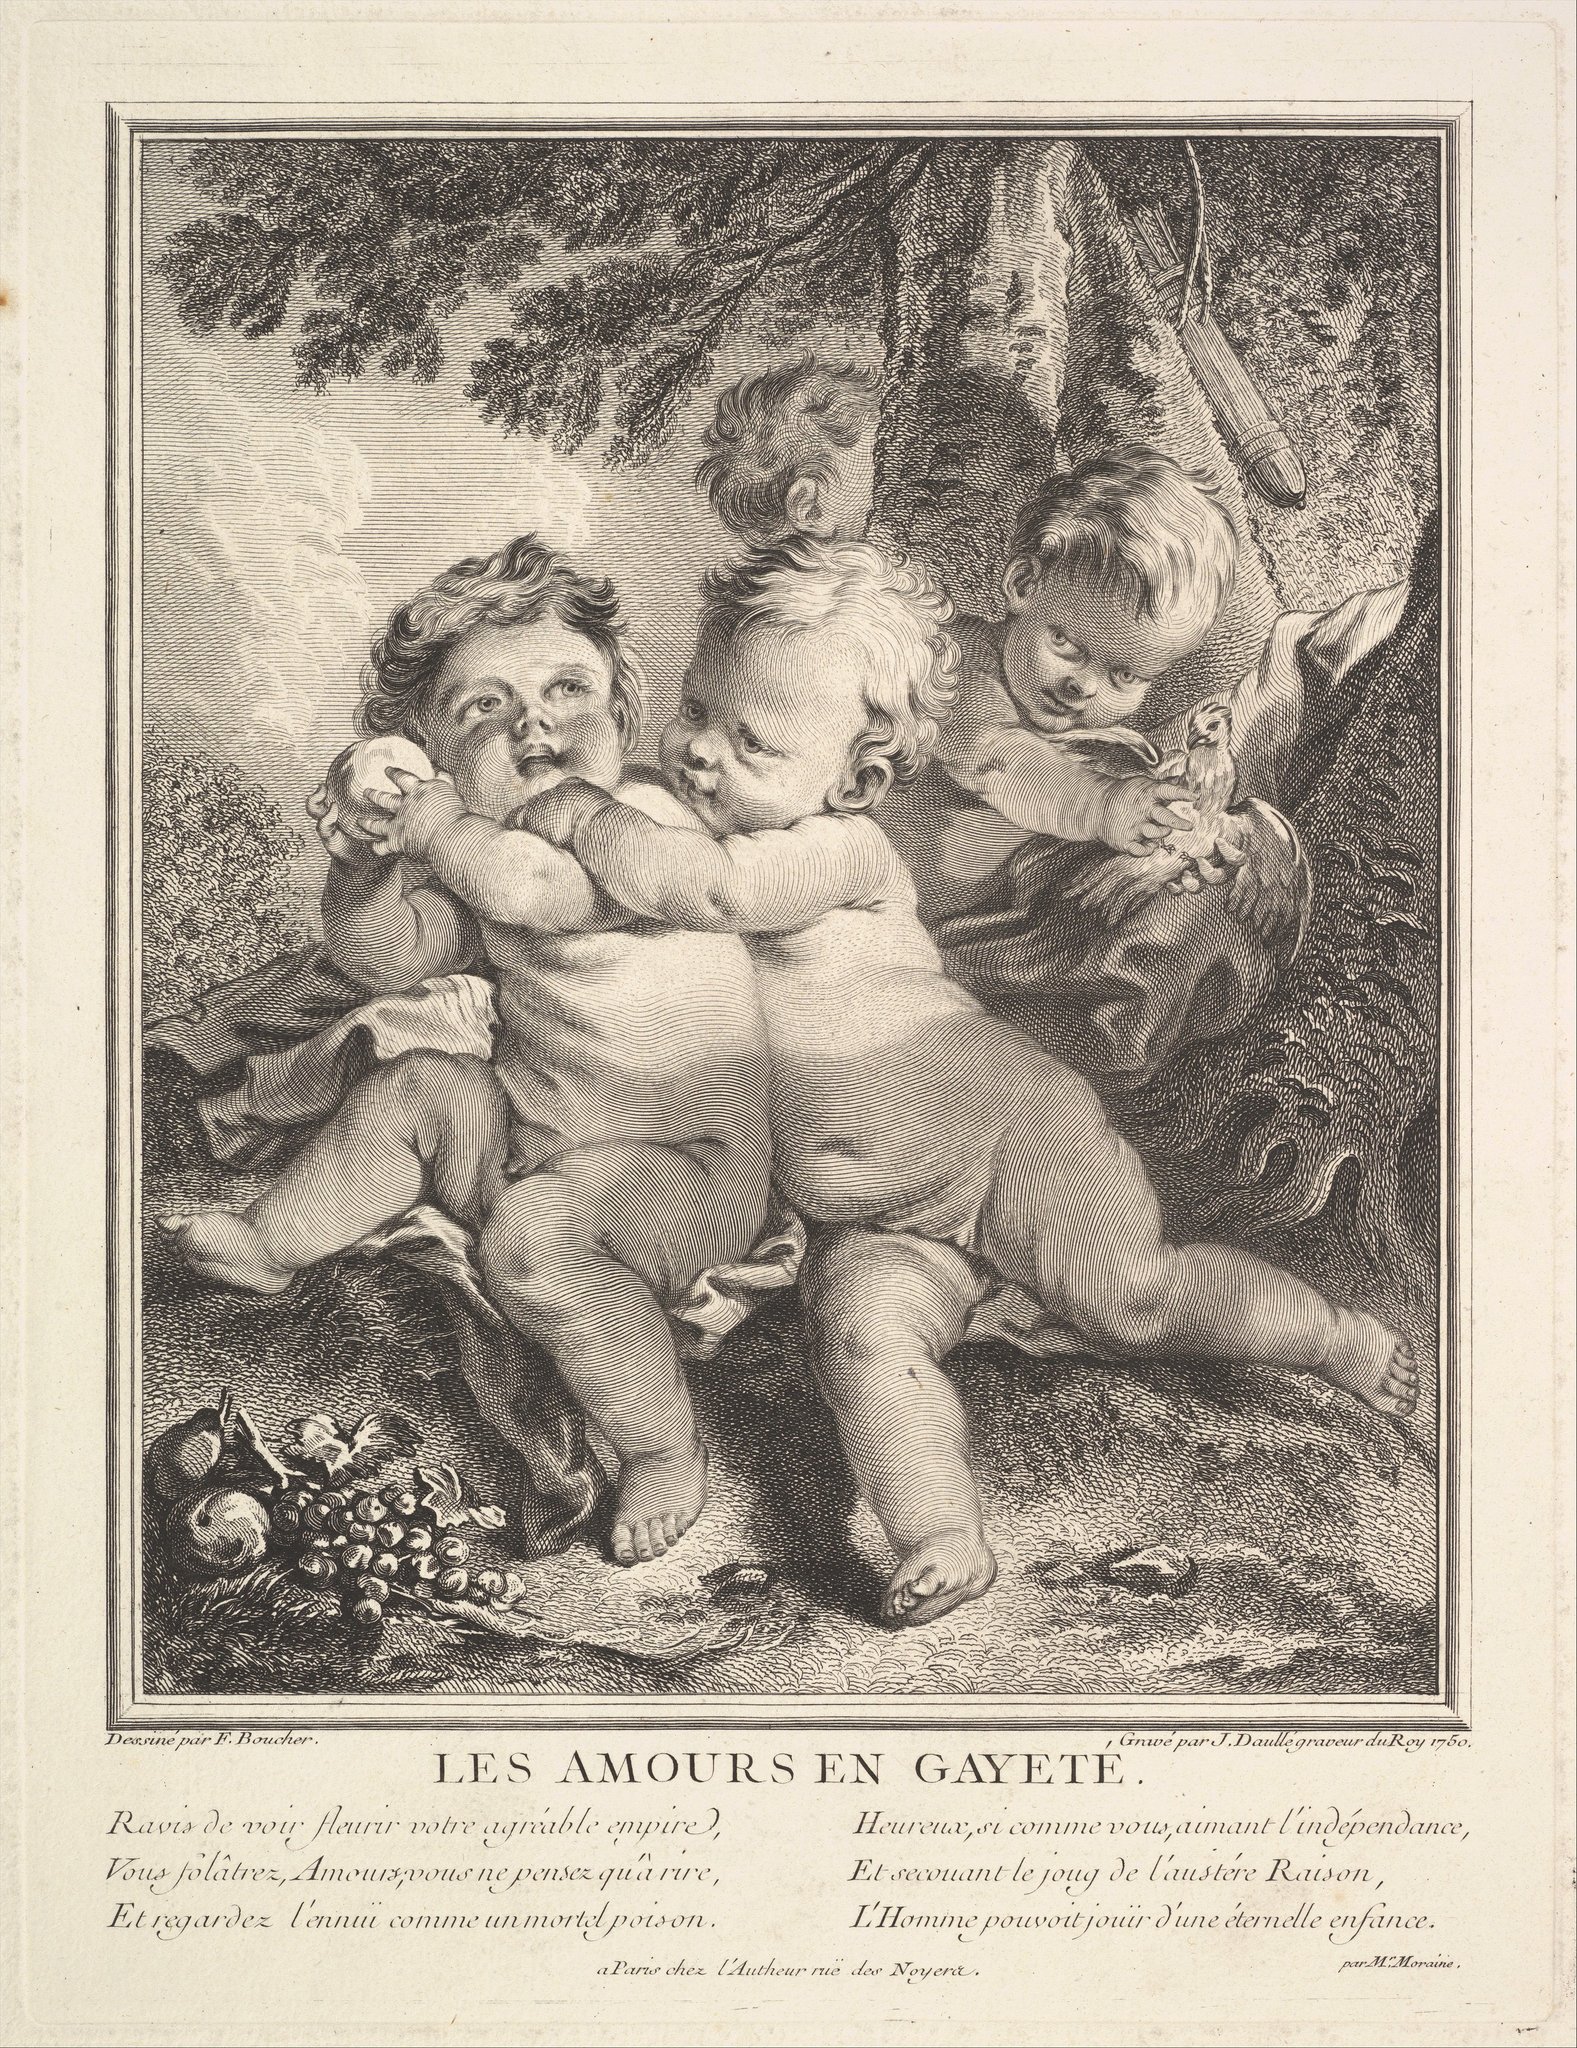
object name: print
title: The Cheerful Cupids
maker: jean daullé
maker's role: artist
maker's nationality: french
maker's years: 1703-1763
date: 1750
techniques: engraving, etching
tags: birds,playing,cupid